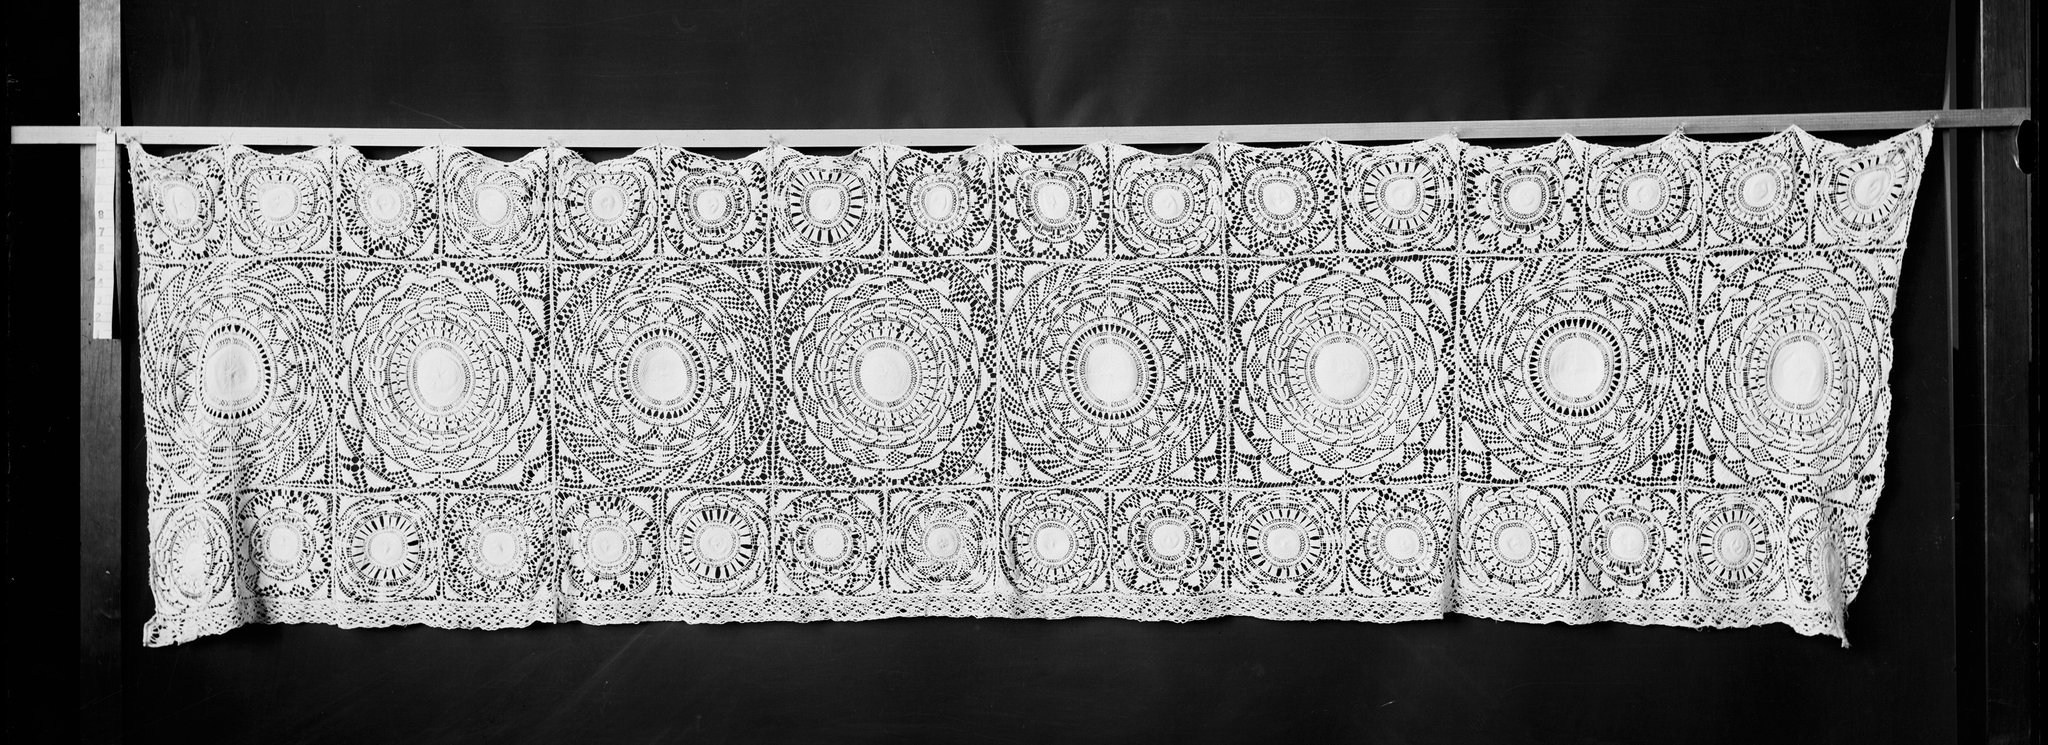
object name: cover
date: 1601-1633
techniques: embroidery